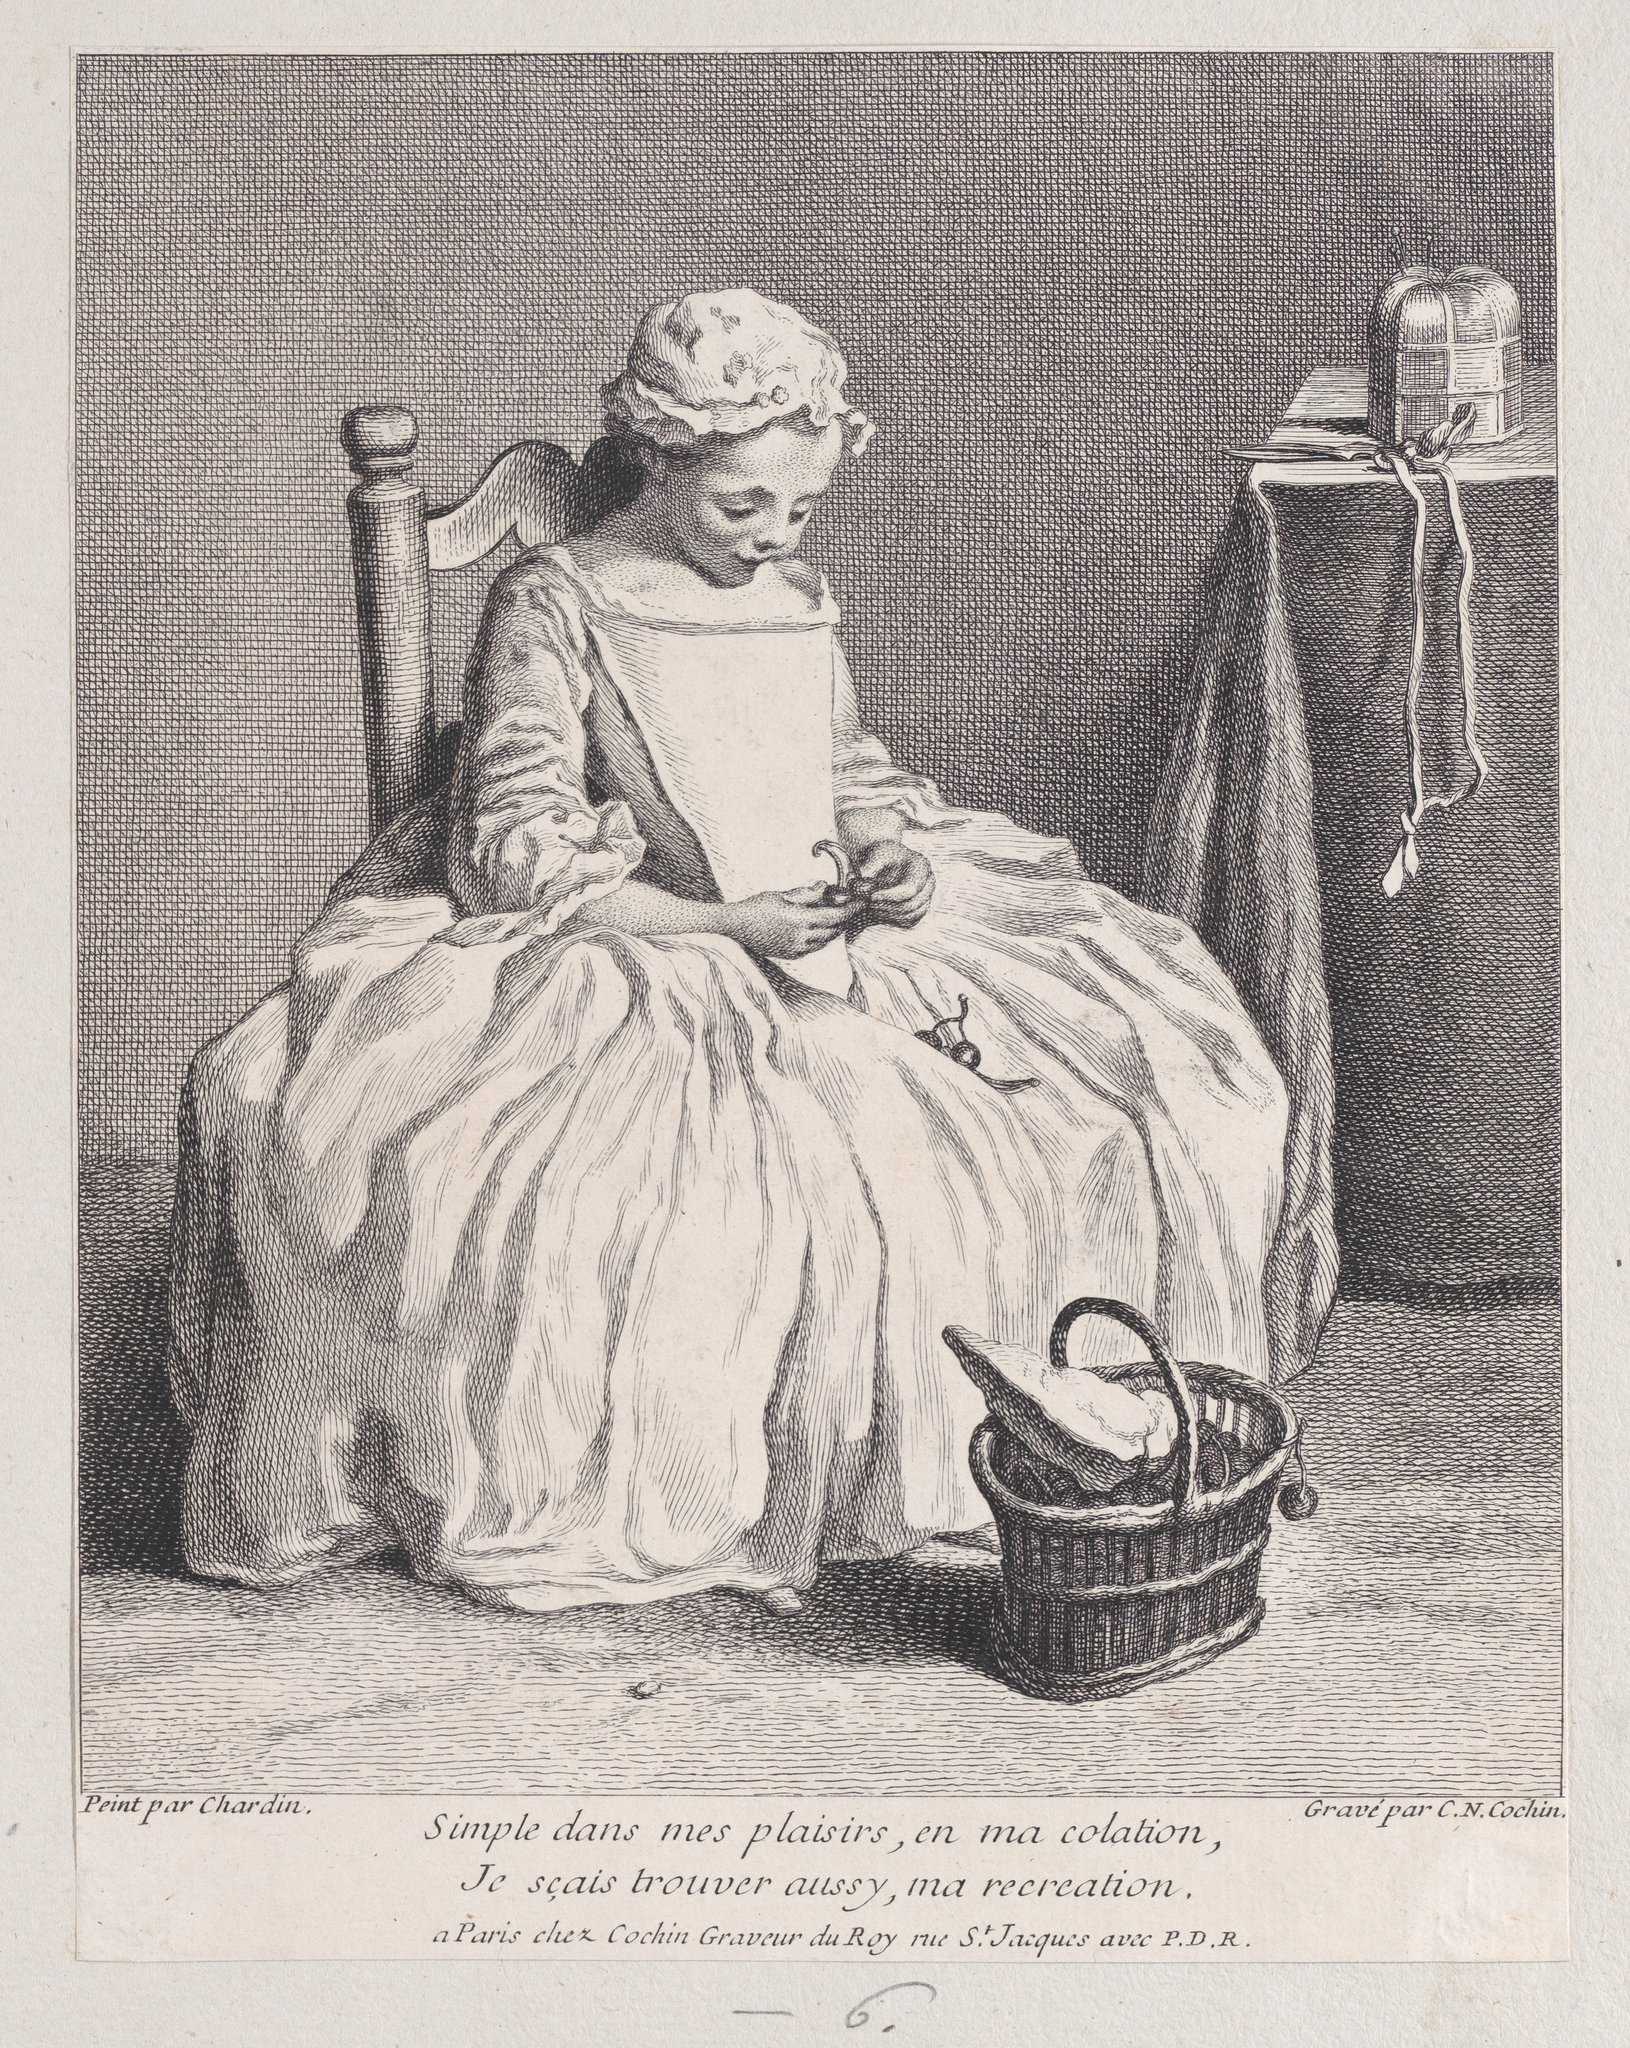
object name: print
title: Little Girl with Cherries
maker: charles nicolas cochin i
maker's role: artist and publisher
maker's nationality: french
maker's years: 1688-1754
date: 1738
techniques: etching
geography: paris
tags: cherries,girls,baskets